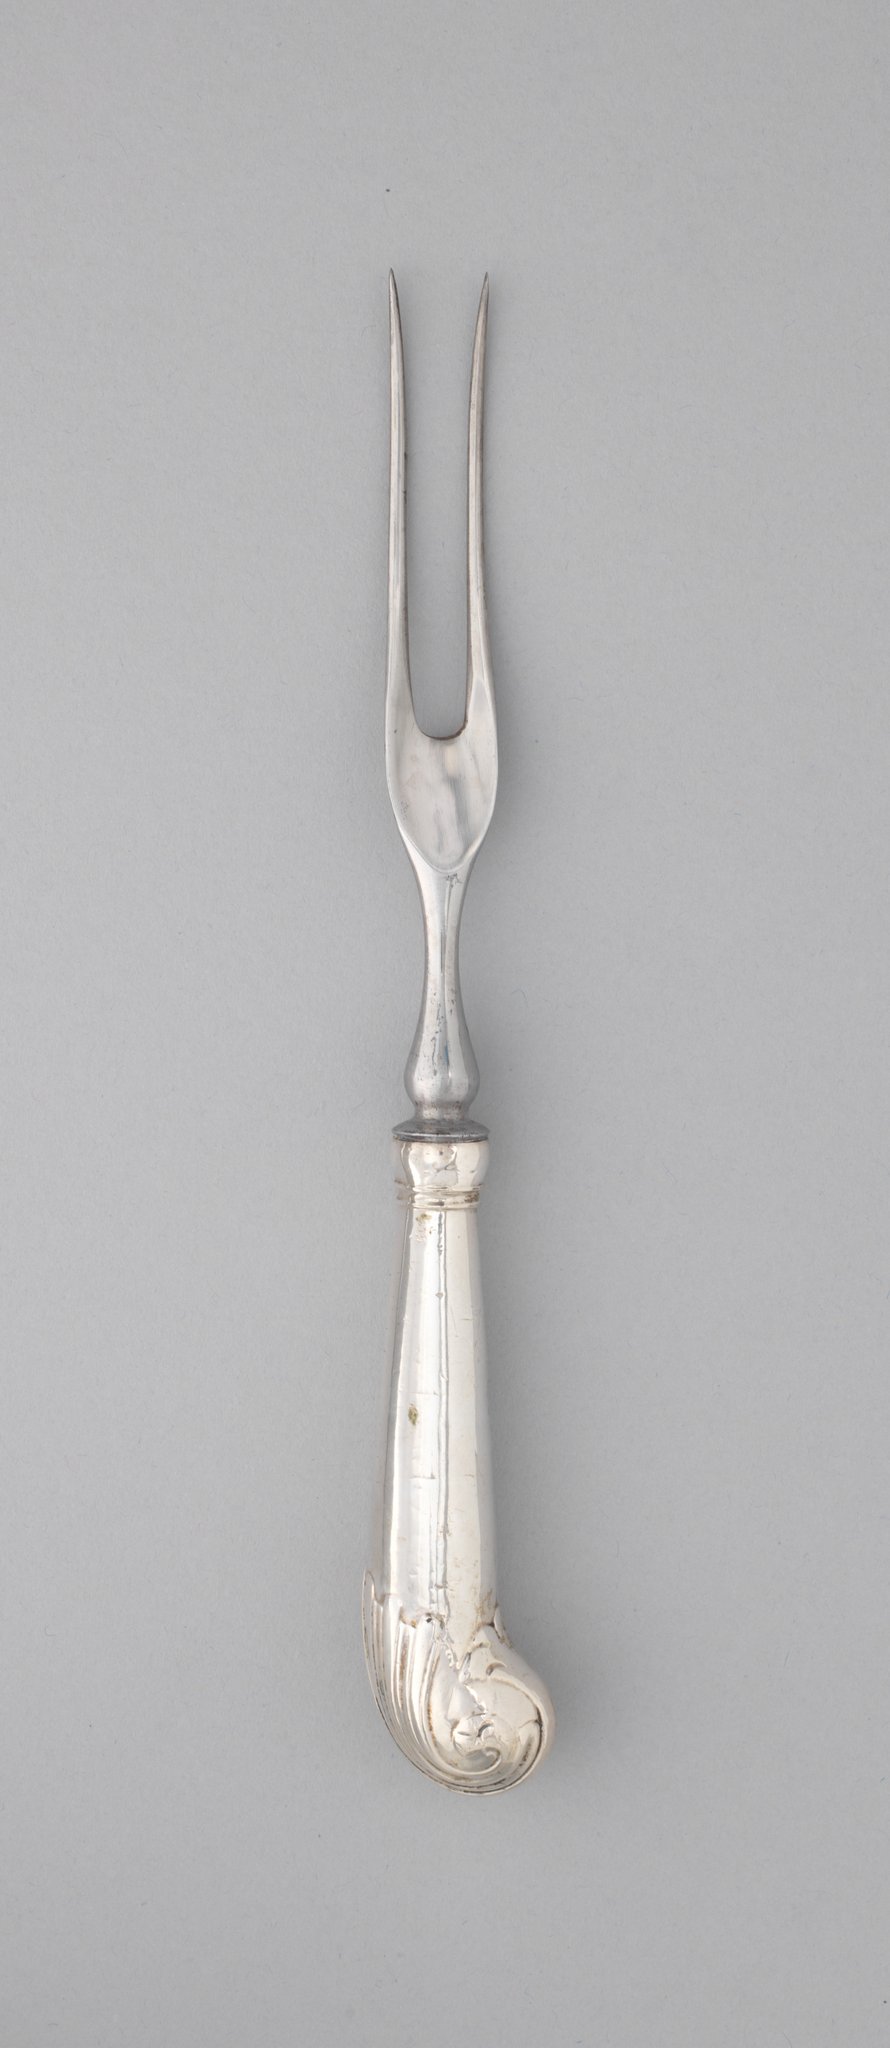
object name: fork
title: Twelve forks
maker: i. h., sheffield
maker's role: maker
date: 1767-1800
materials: silver, steel